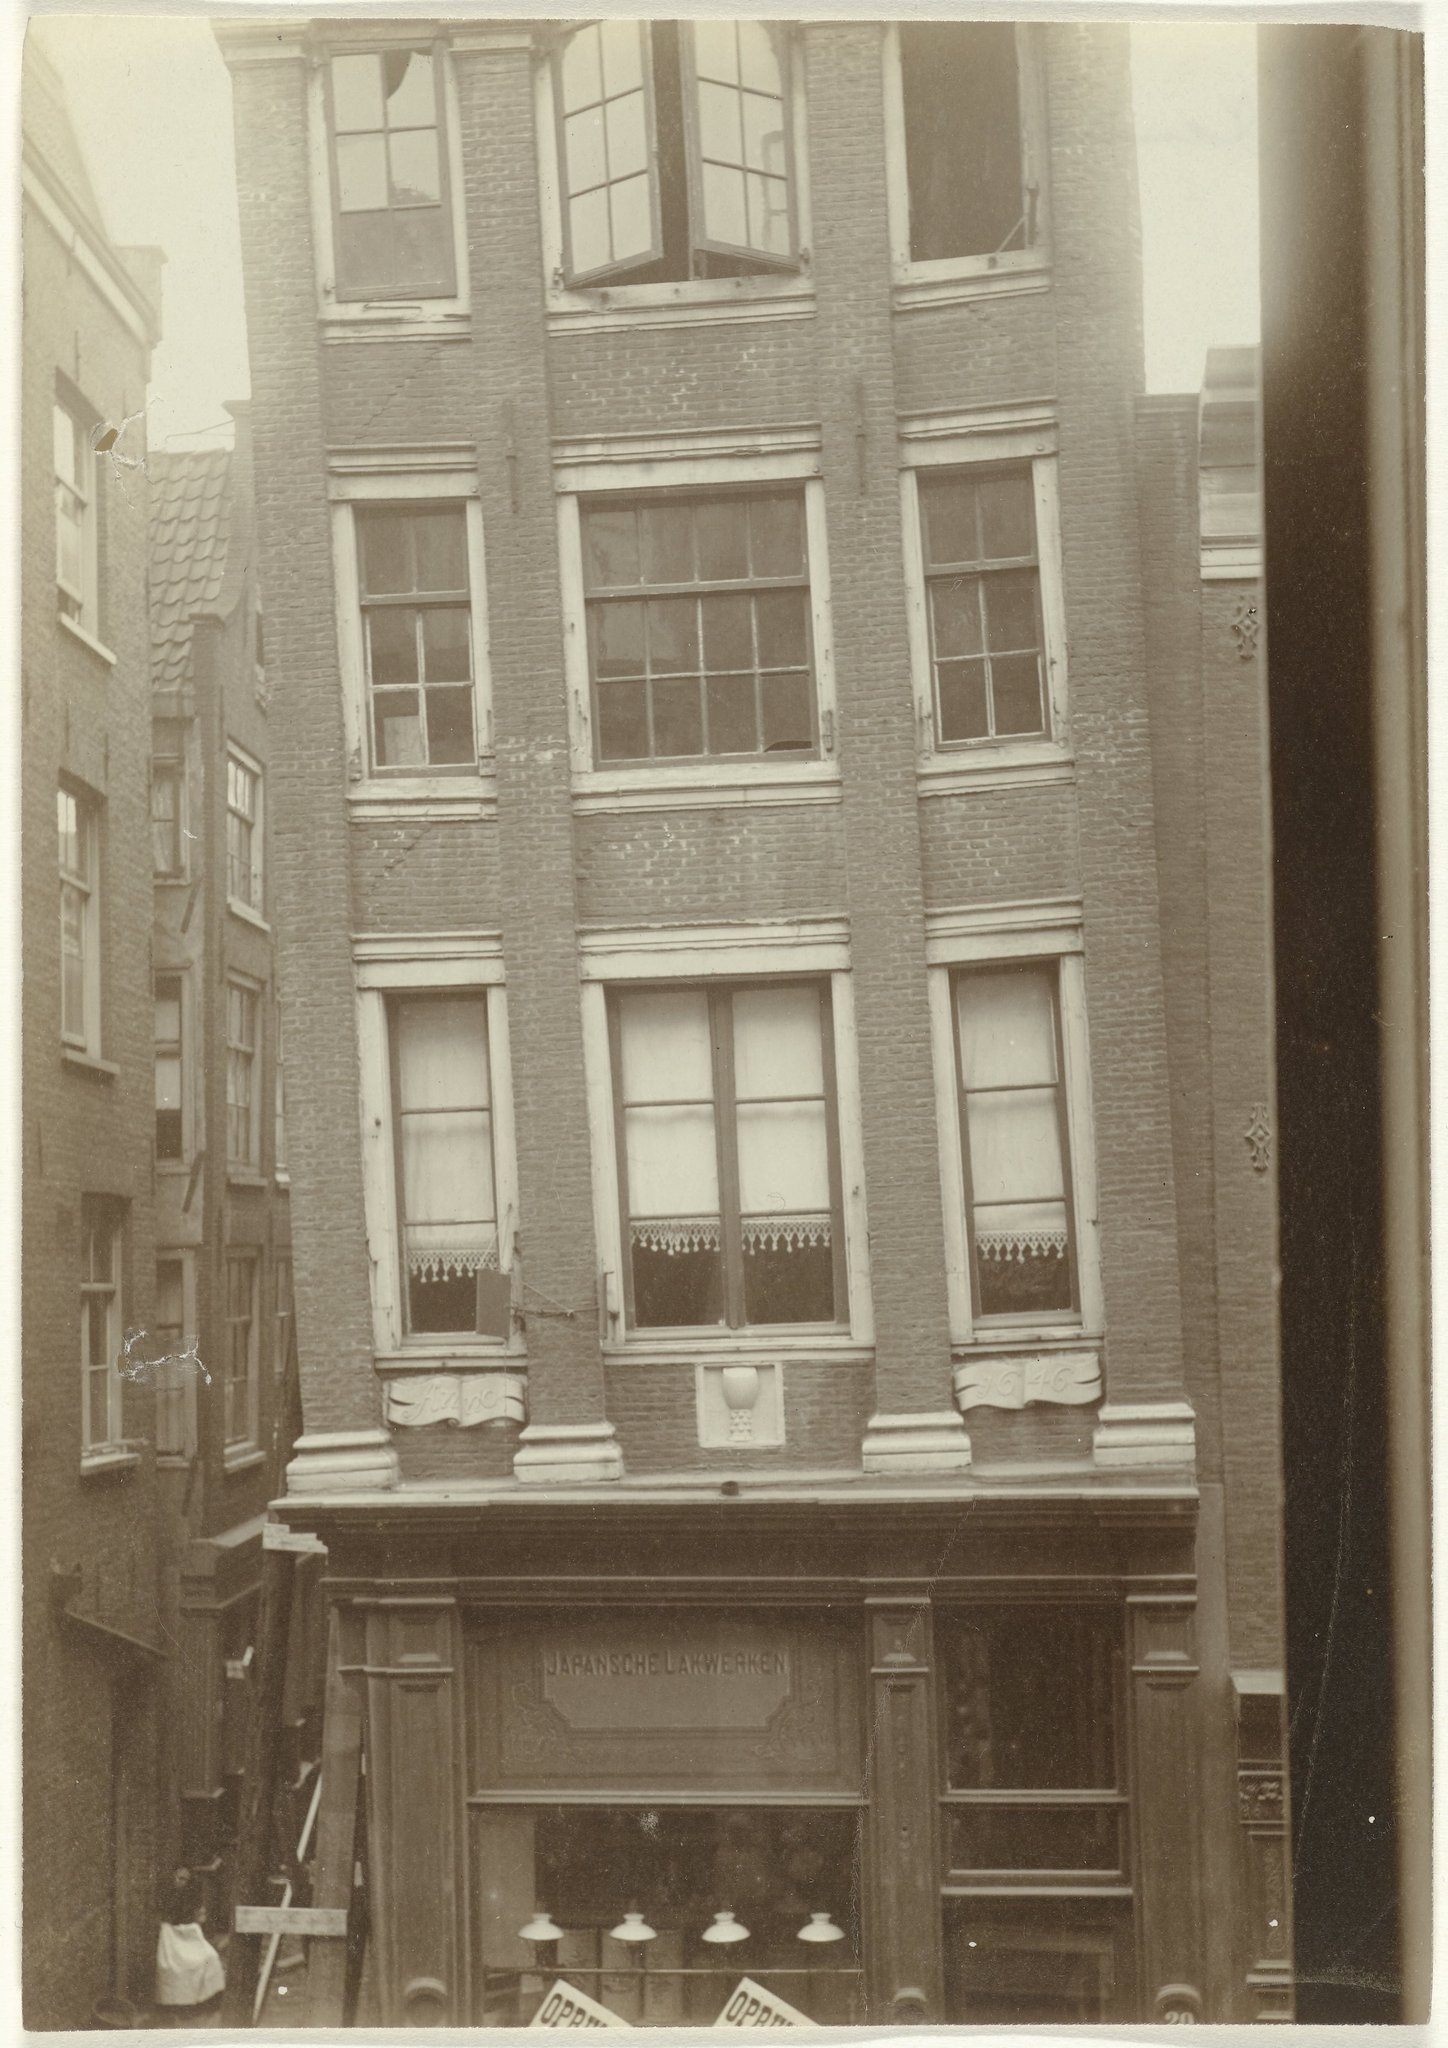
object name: photograph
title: Gezicht op Damstraat 20 met het magazijn van Japansche kunst-lakwerken van Wybe Reijenga Tz.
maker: Anonymous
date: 1881-1883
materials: paper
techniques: matte daylight collodion silver print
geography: amsterdam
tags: house combined with shop